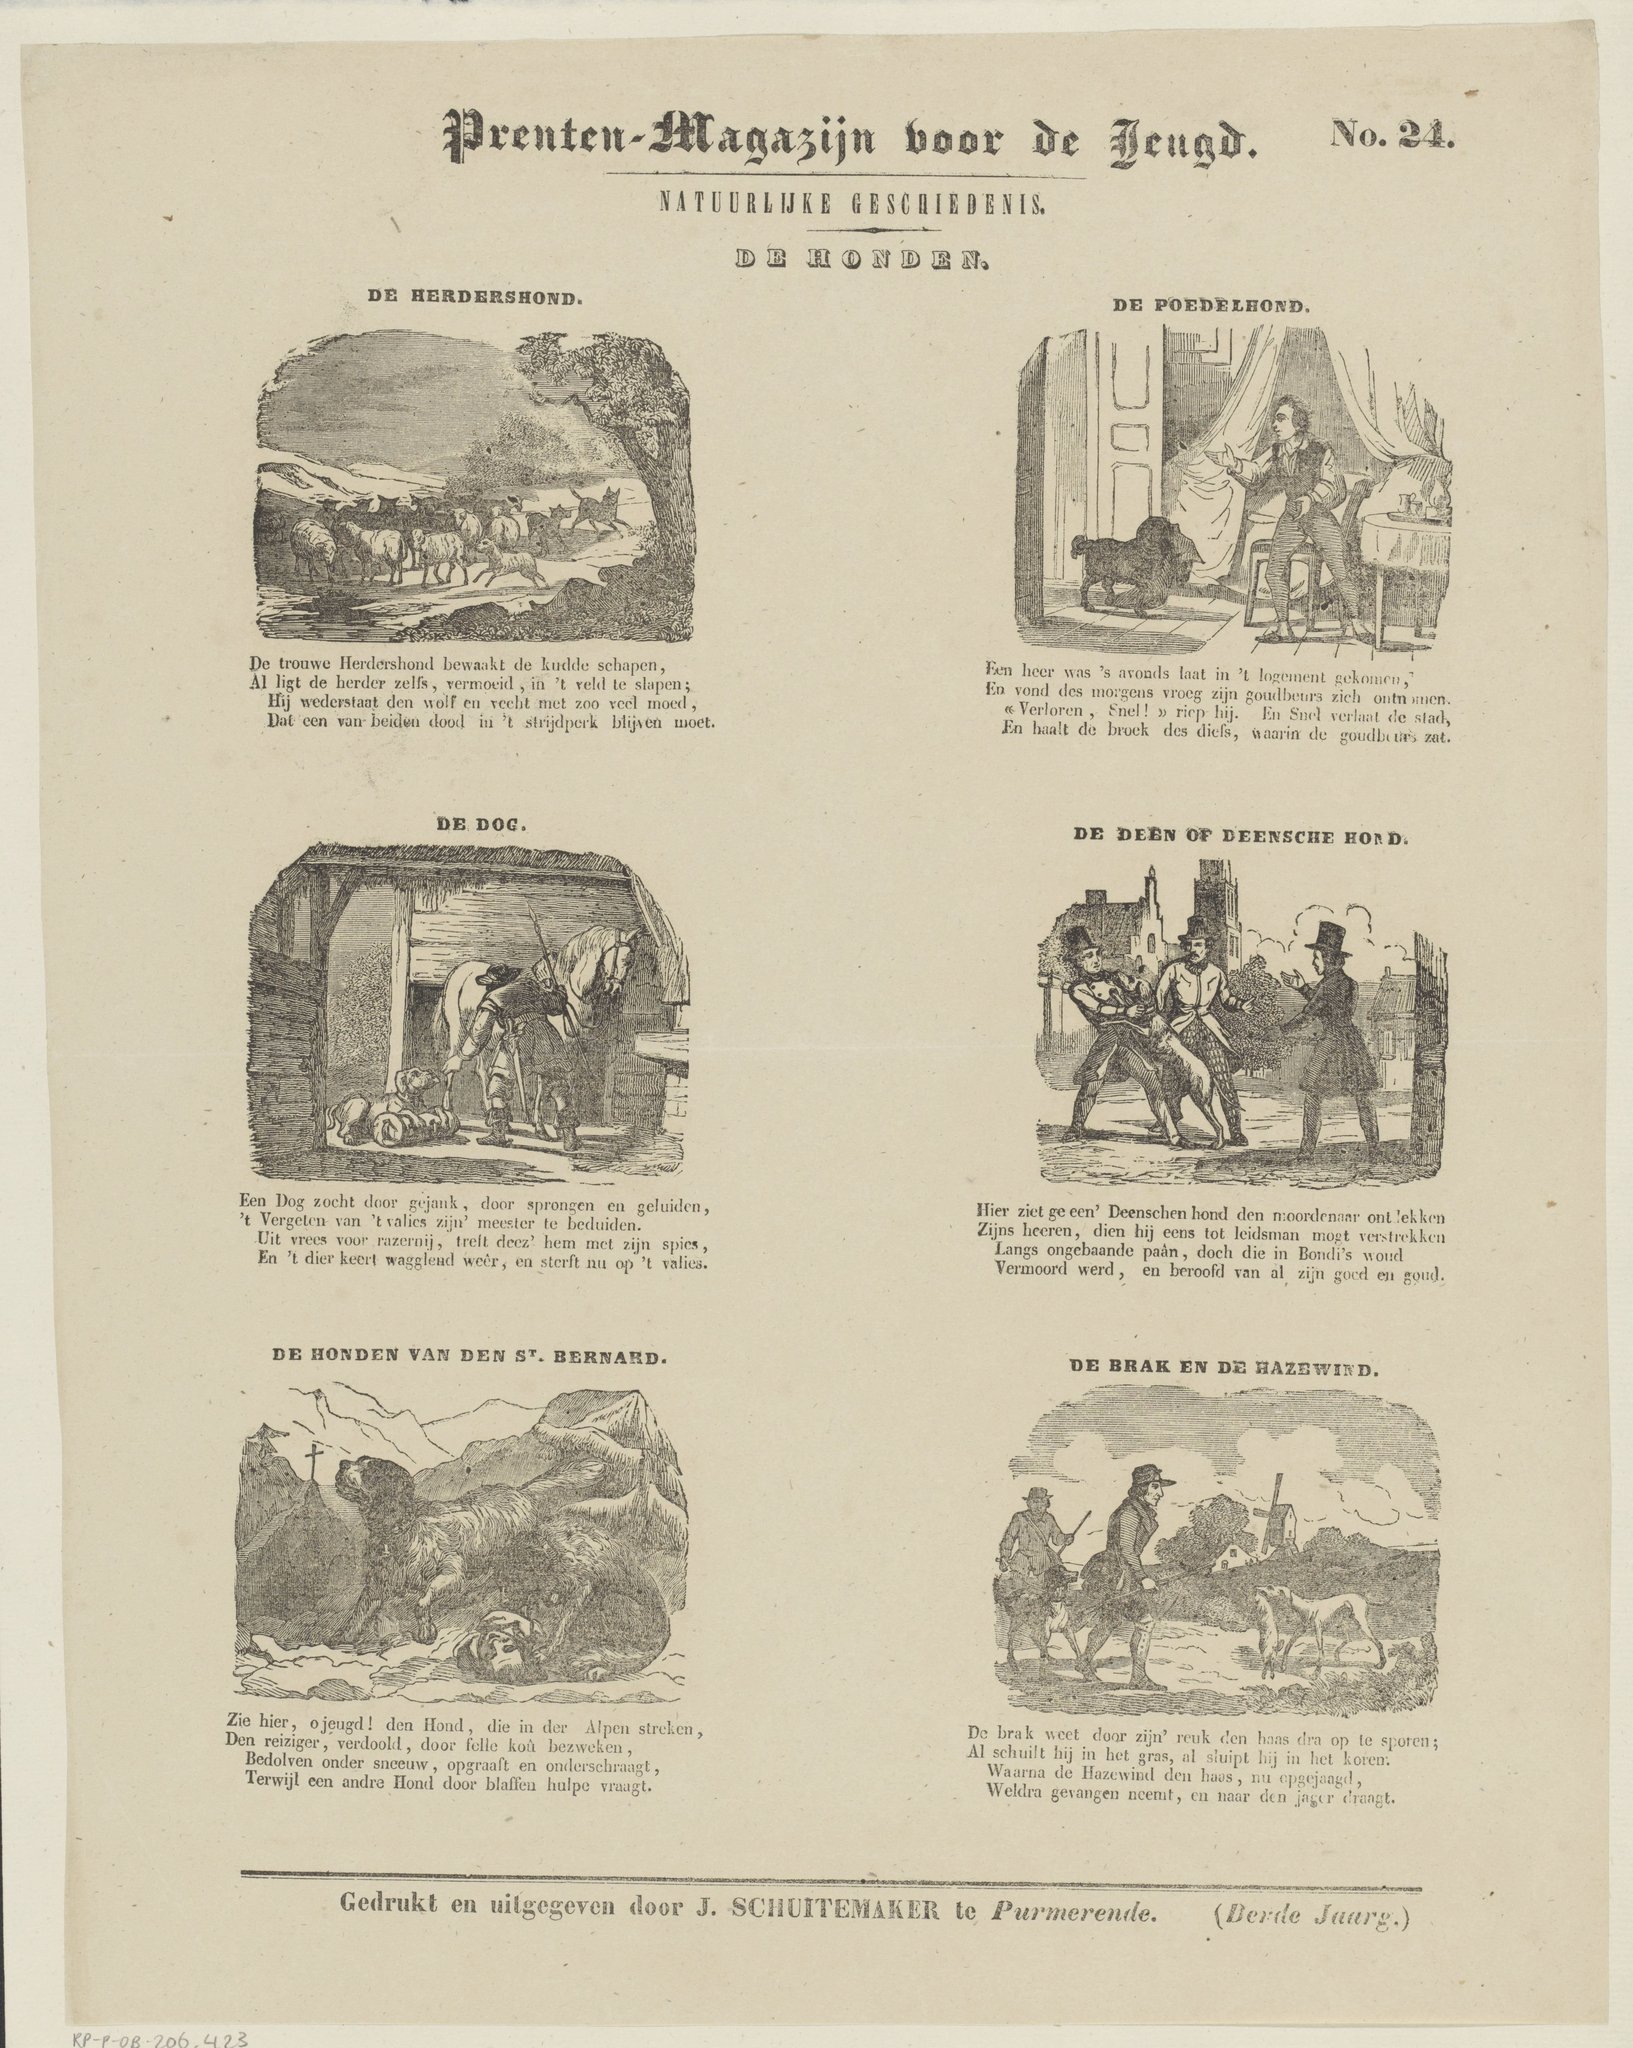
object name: popular print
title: Natuurlijke geschiedenis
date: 1844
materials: paper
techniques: letterpress printing, engraving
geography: purmerend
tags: dog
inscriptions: collector's mark: Lugt 2760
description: Blad met 6 voorstellingen van verschillende honden, zoals een herdershond, een poedel en een Sint-bernard. Boven elke voorstelling een titel en onder elke voorstelling een vierregelig vers. Genummerd rechtsboven: No. 24.